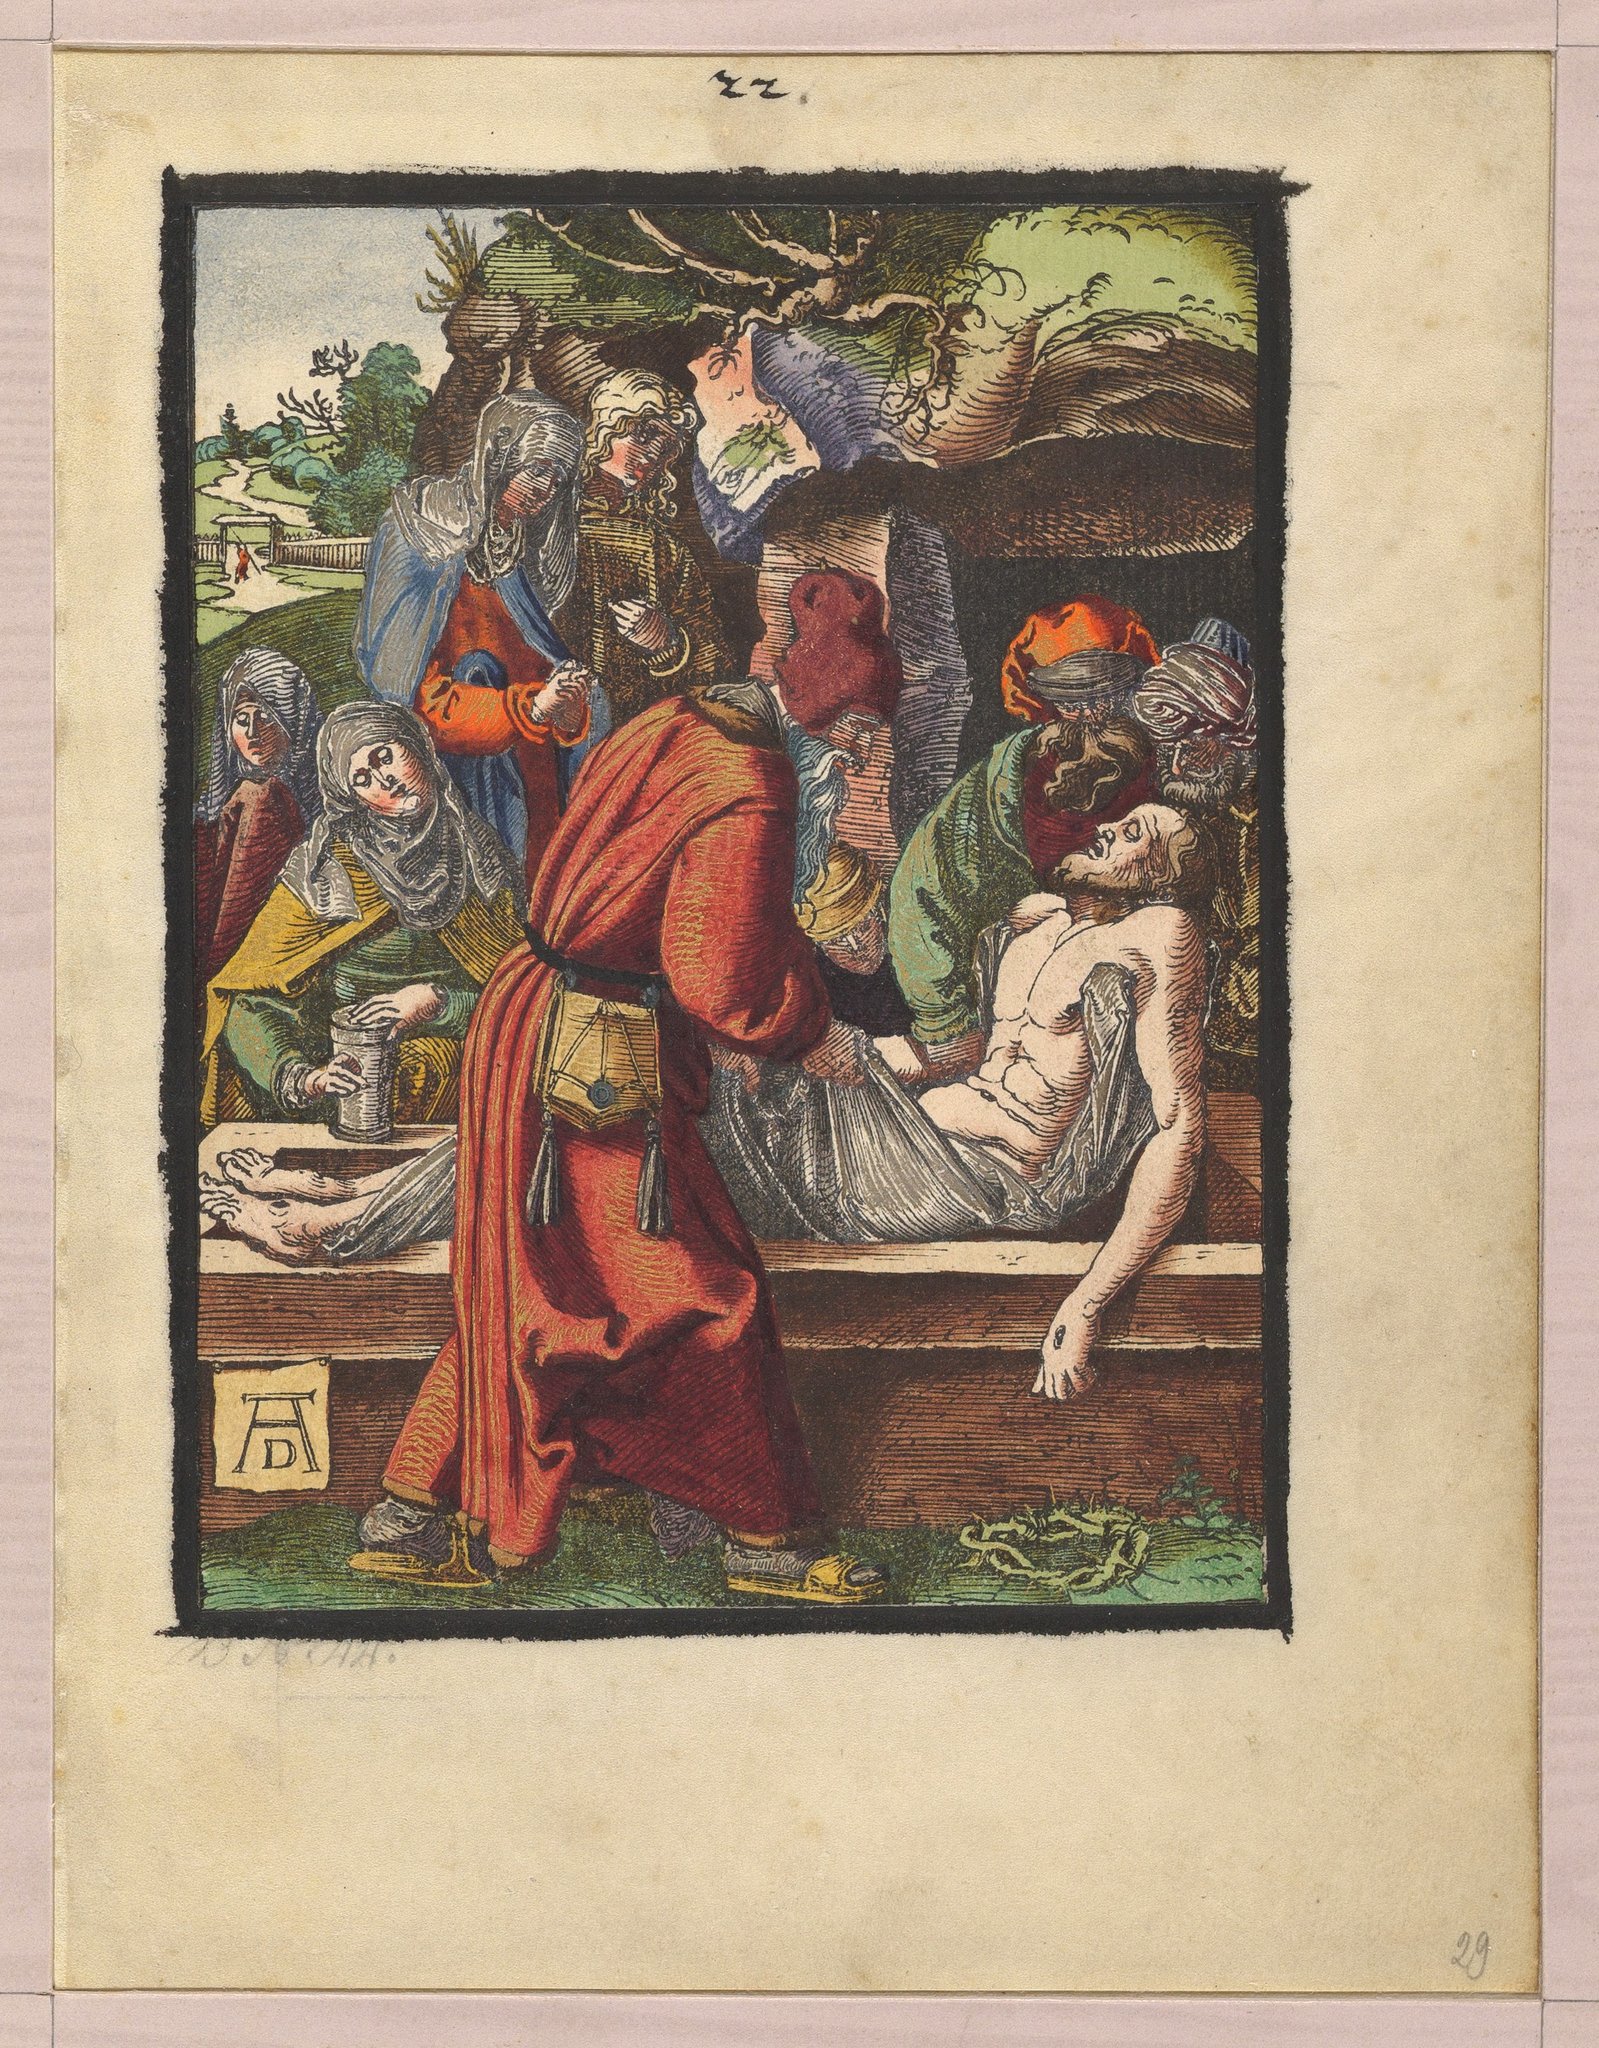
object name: print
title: Deposition, from "The Small Woodcut Passion"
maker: albrecht dürer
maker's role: artist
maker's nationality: german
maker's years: 1471-1528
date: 1509-1510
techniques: hand coloring, woodcut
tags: men,women,burials,death